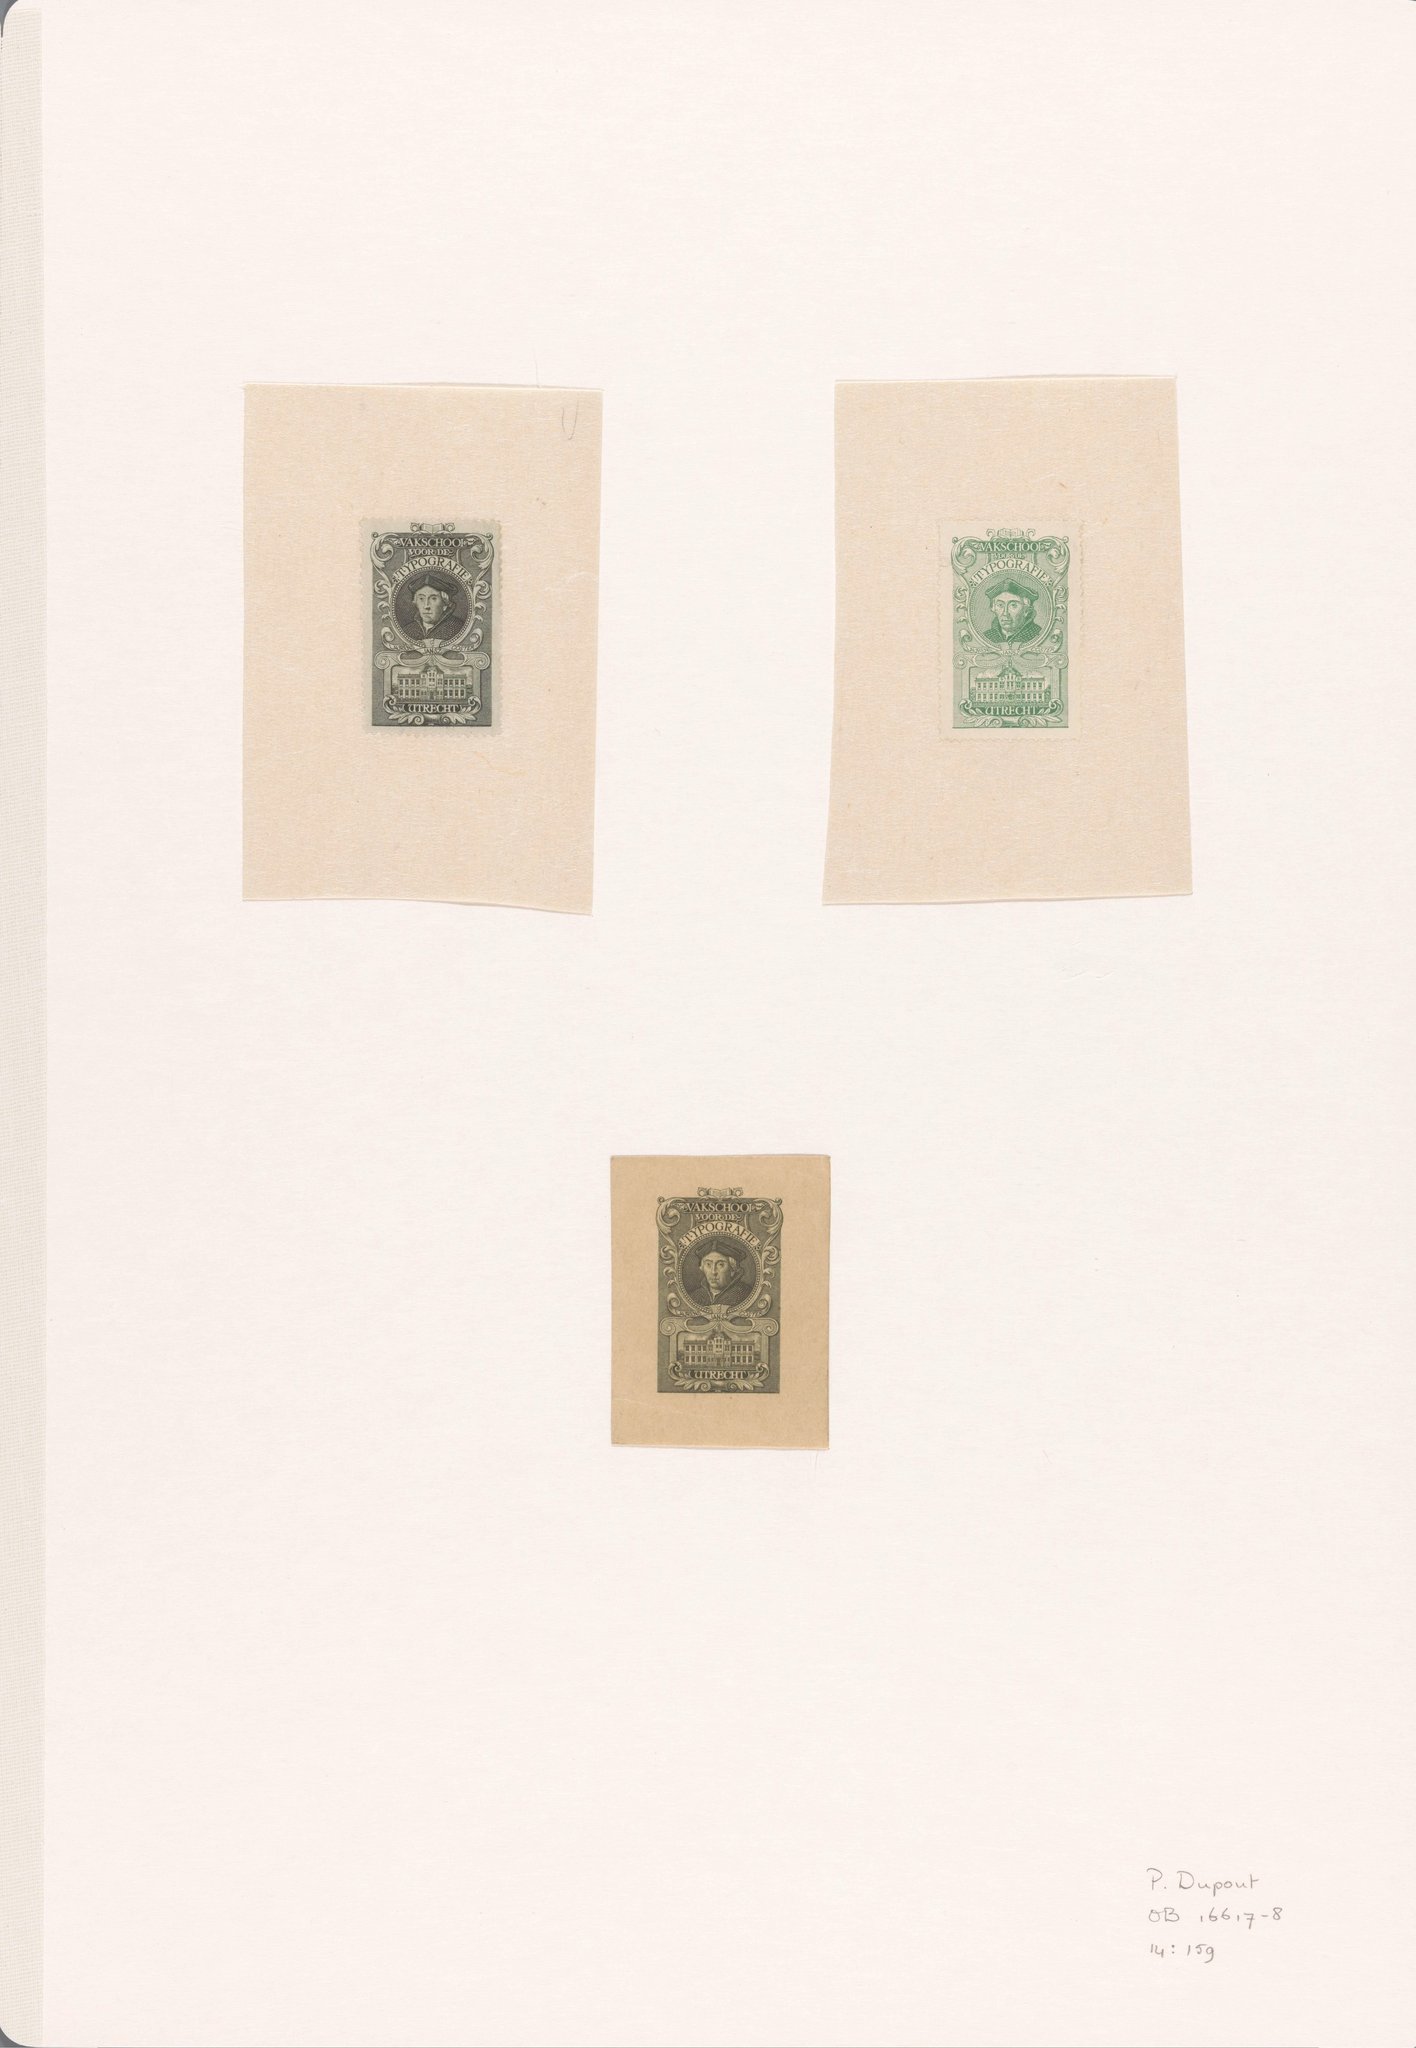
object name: sluitzegel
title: Sluitzegel voor de Vakschool voor de Typografie in Utrecht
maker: pieter dupont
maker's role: draughtsman, print maker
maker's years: 1870-1911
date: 1910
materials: paper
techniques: engraving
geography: amsterdam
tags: haarlem, further education, historical persons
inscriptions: collector's mark: Lugt 2228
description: Boven een portret van Laurens Janszoon Coster. Onder de Vakschool voor de Typografie in Utrecht.